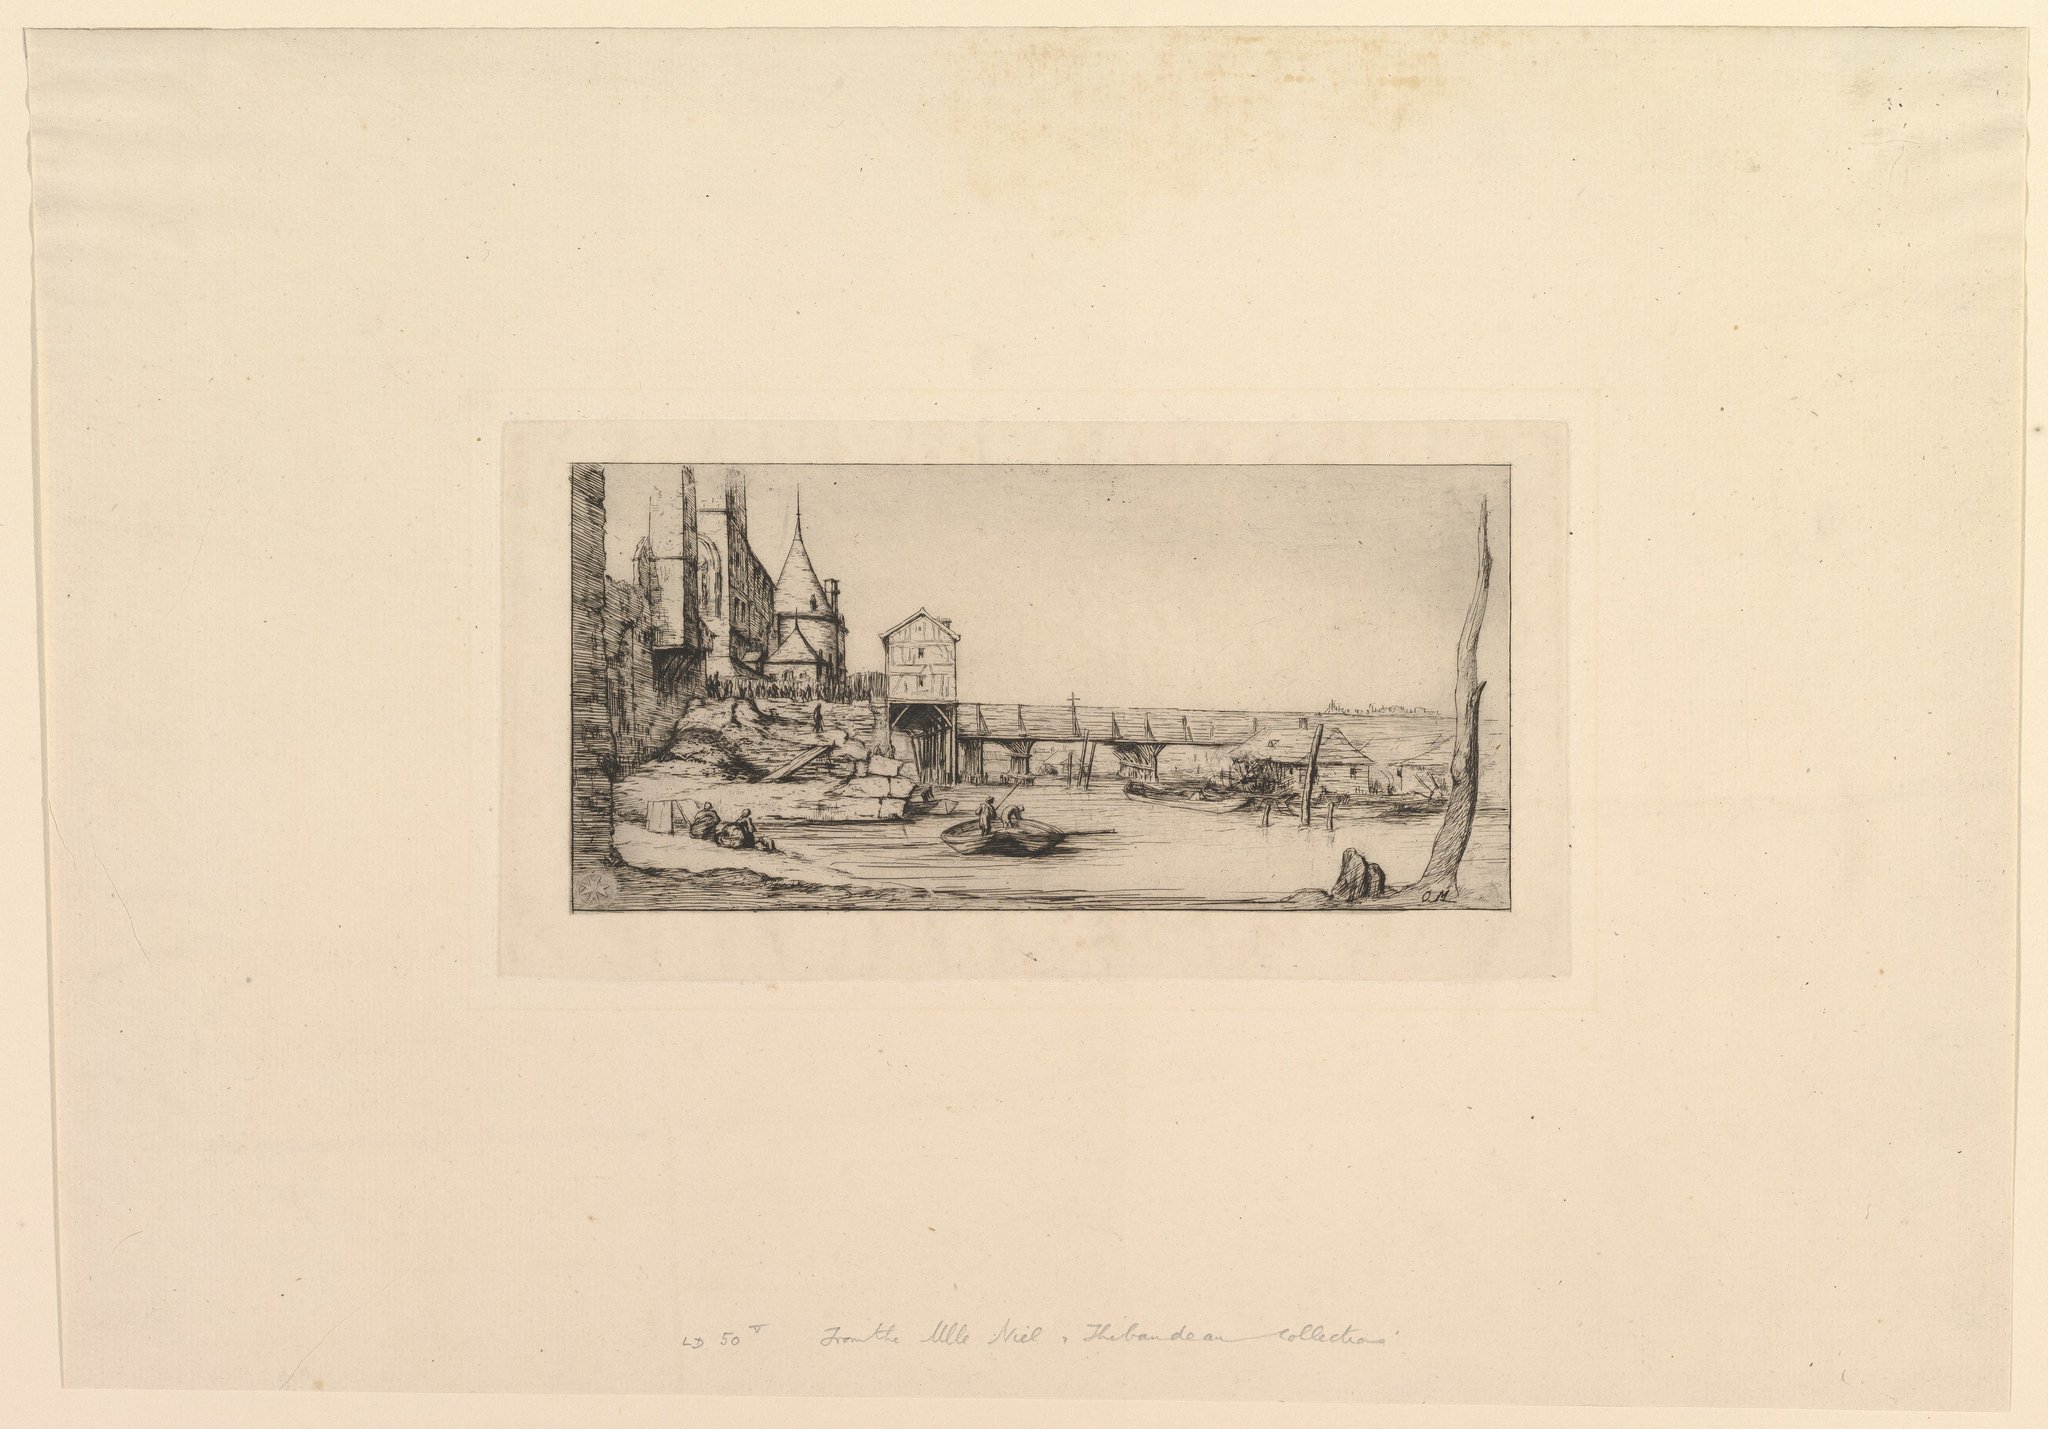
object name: print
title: Passerelle du Pont-au-Change, après l'incendie de 1621 (The Footbridge temporarily replacing the Pont-au-Change, Paris, after the fire of 1621)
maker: charles meryon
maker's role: artist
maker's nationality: french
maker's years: 1821-1868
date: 1860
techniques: etching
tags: buildings,bridges,boats,paris